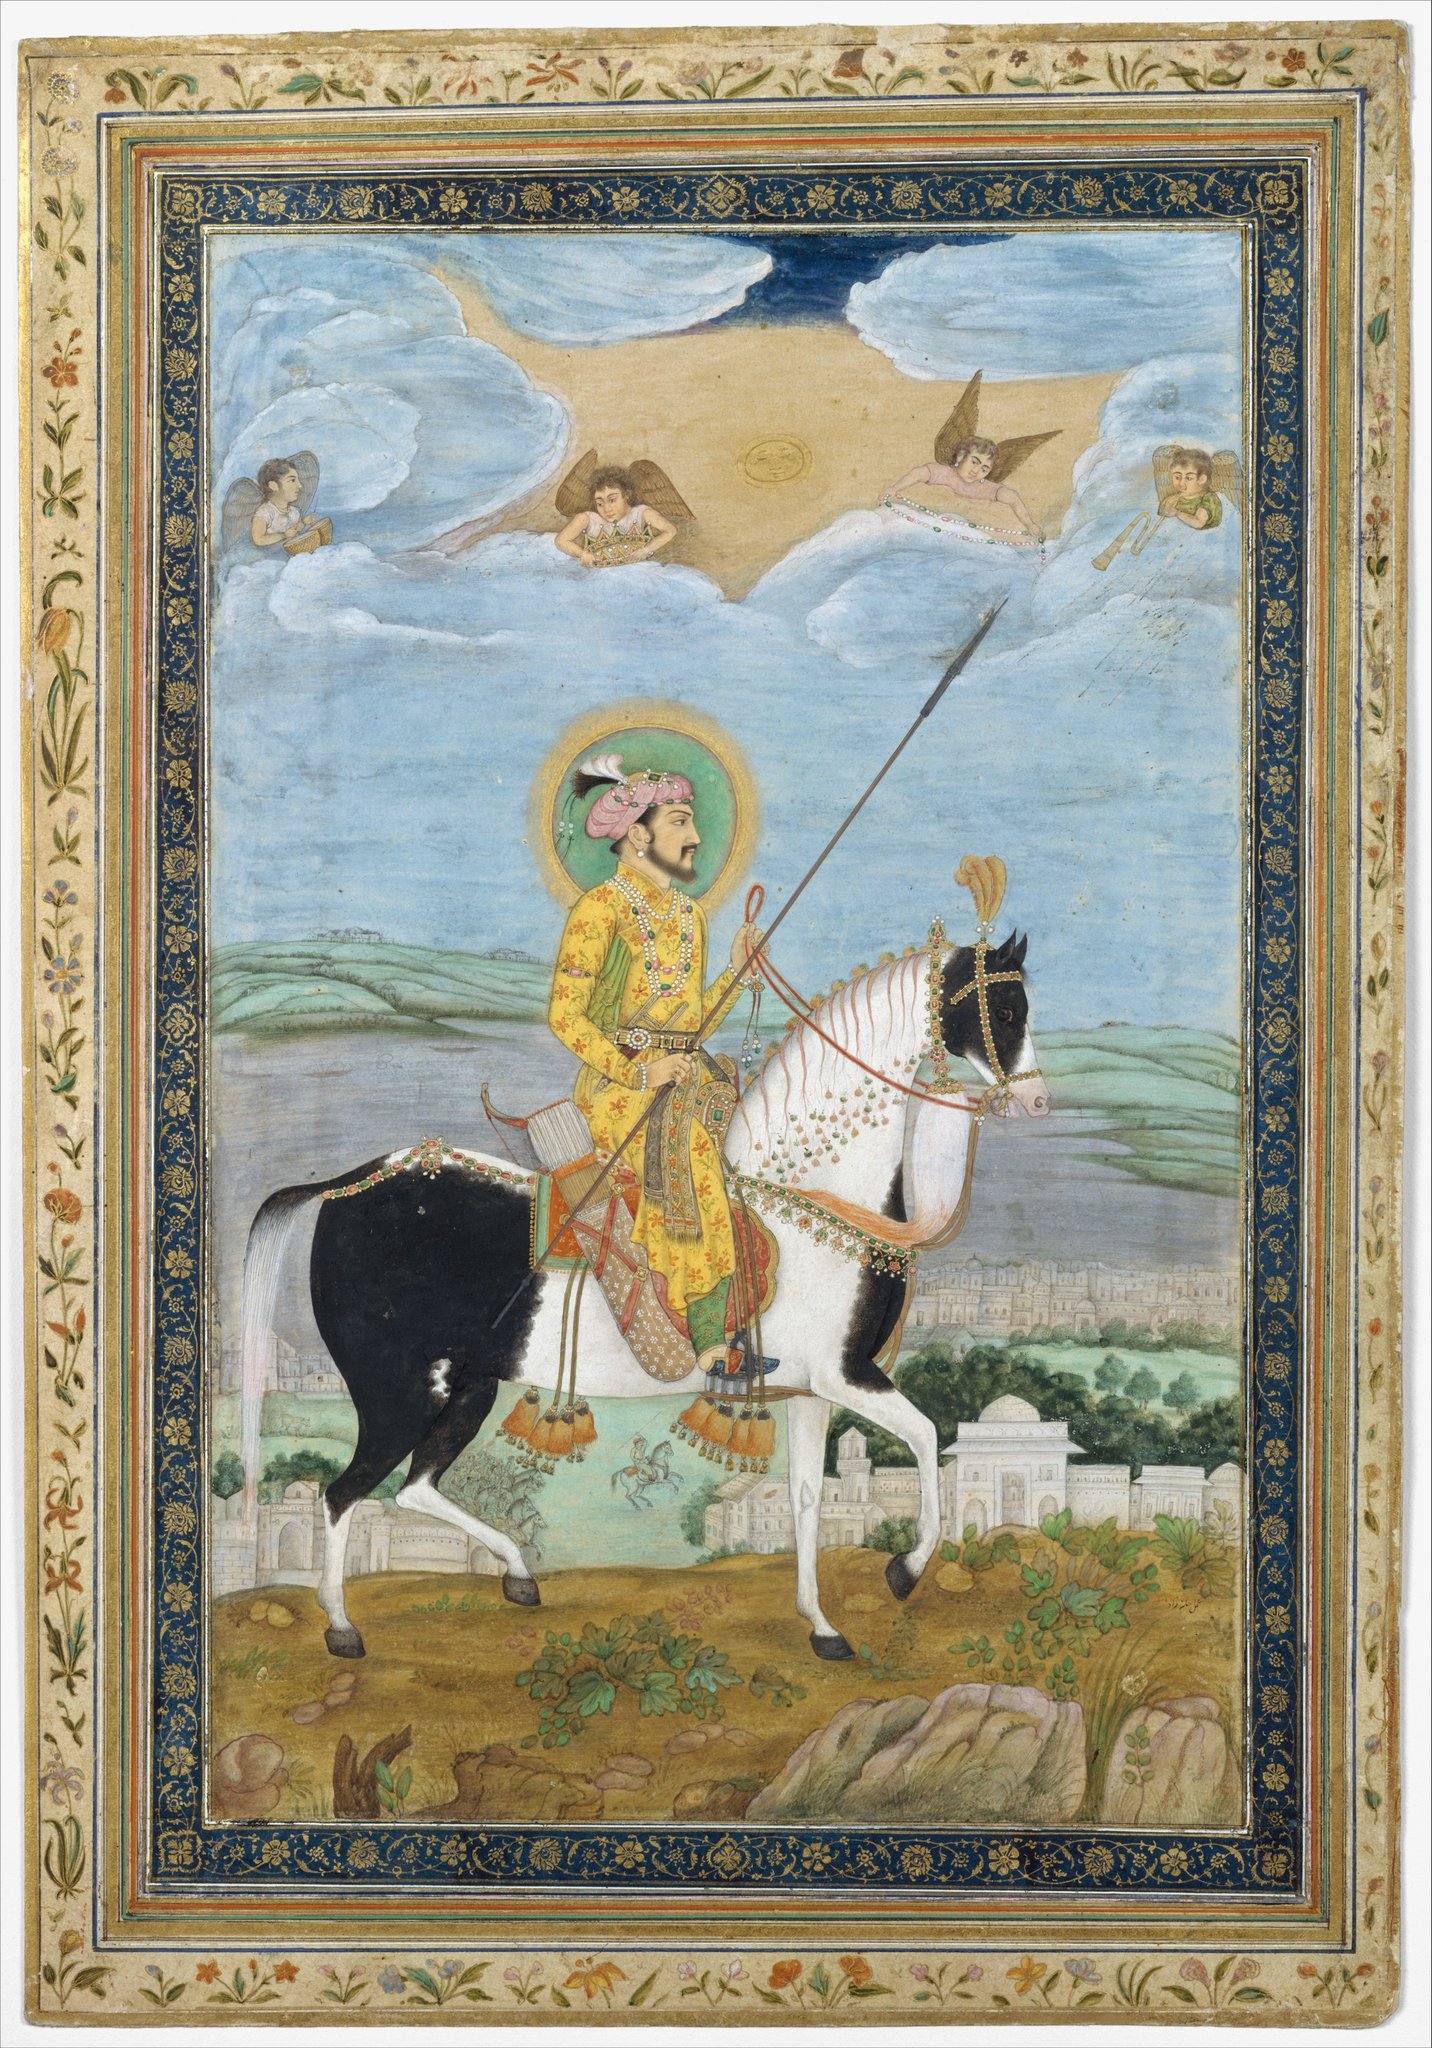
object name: illustrated album leaf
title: Portrait of Shah Jahan on Horseback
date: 1801-1900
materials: gold, ink, paper, watercolor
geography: india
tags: weapons,men,profiles,horses